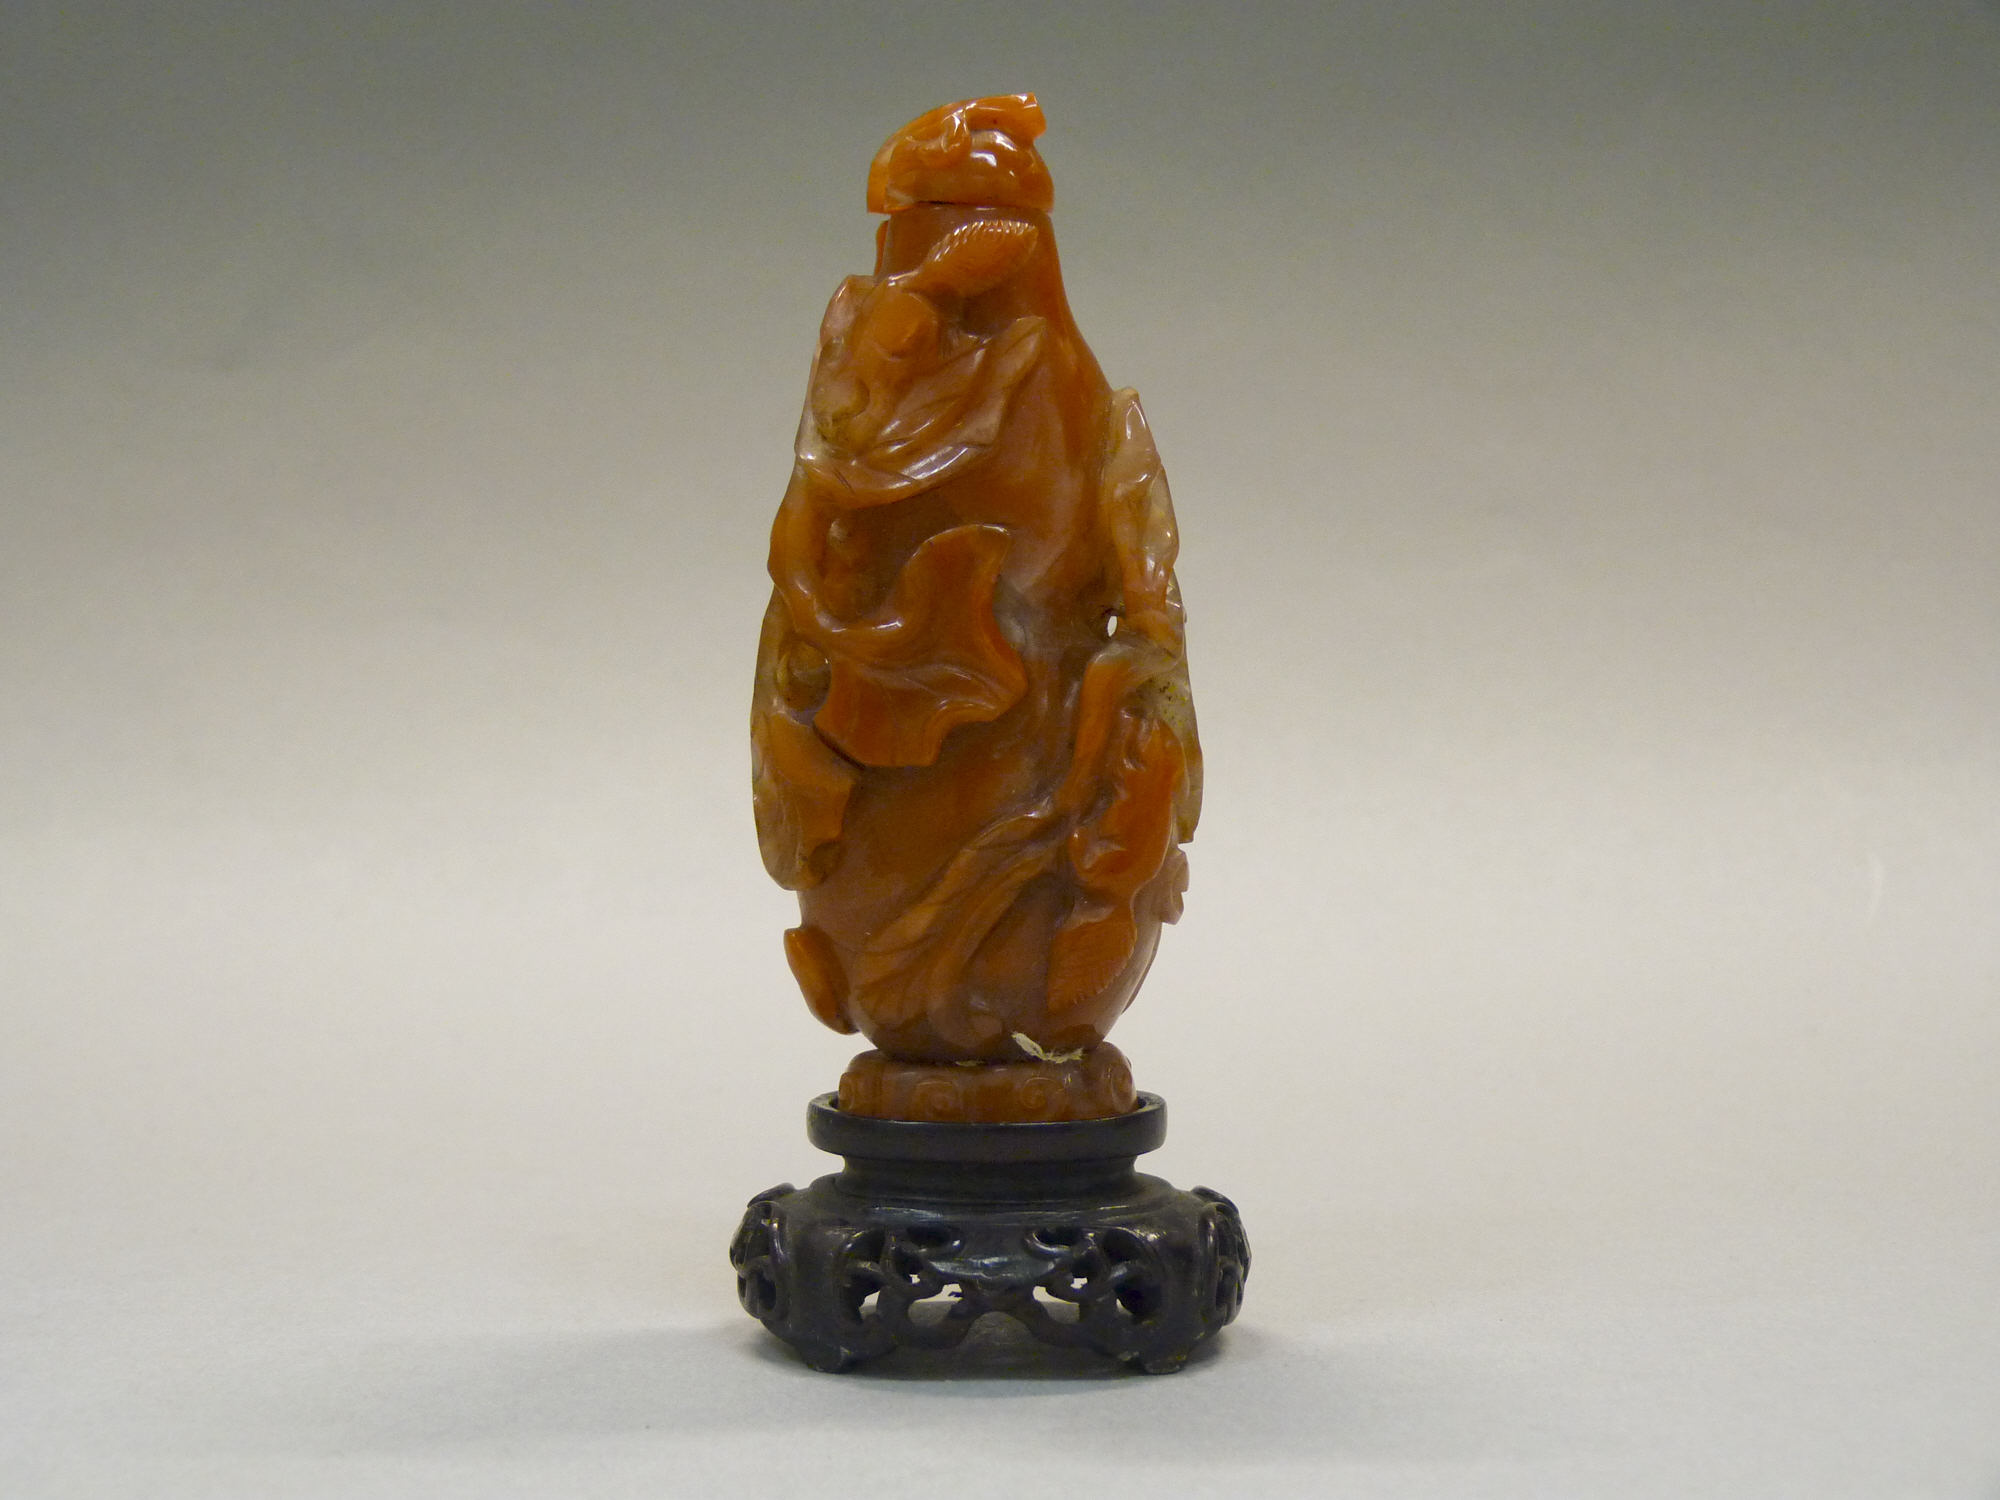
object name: snuff bottle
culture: chinese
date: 1736-1795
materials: stone, gemstone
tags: squirrels